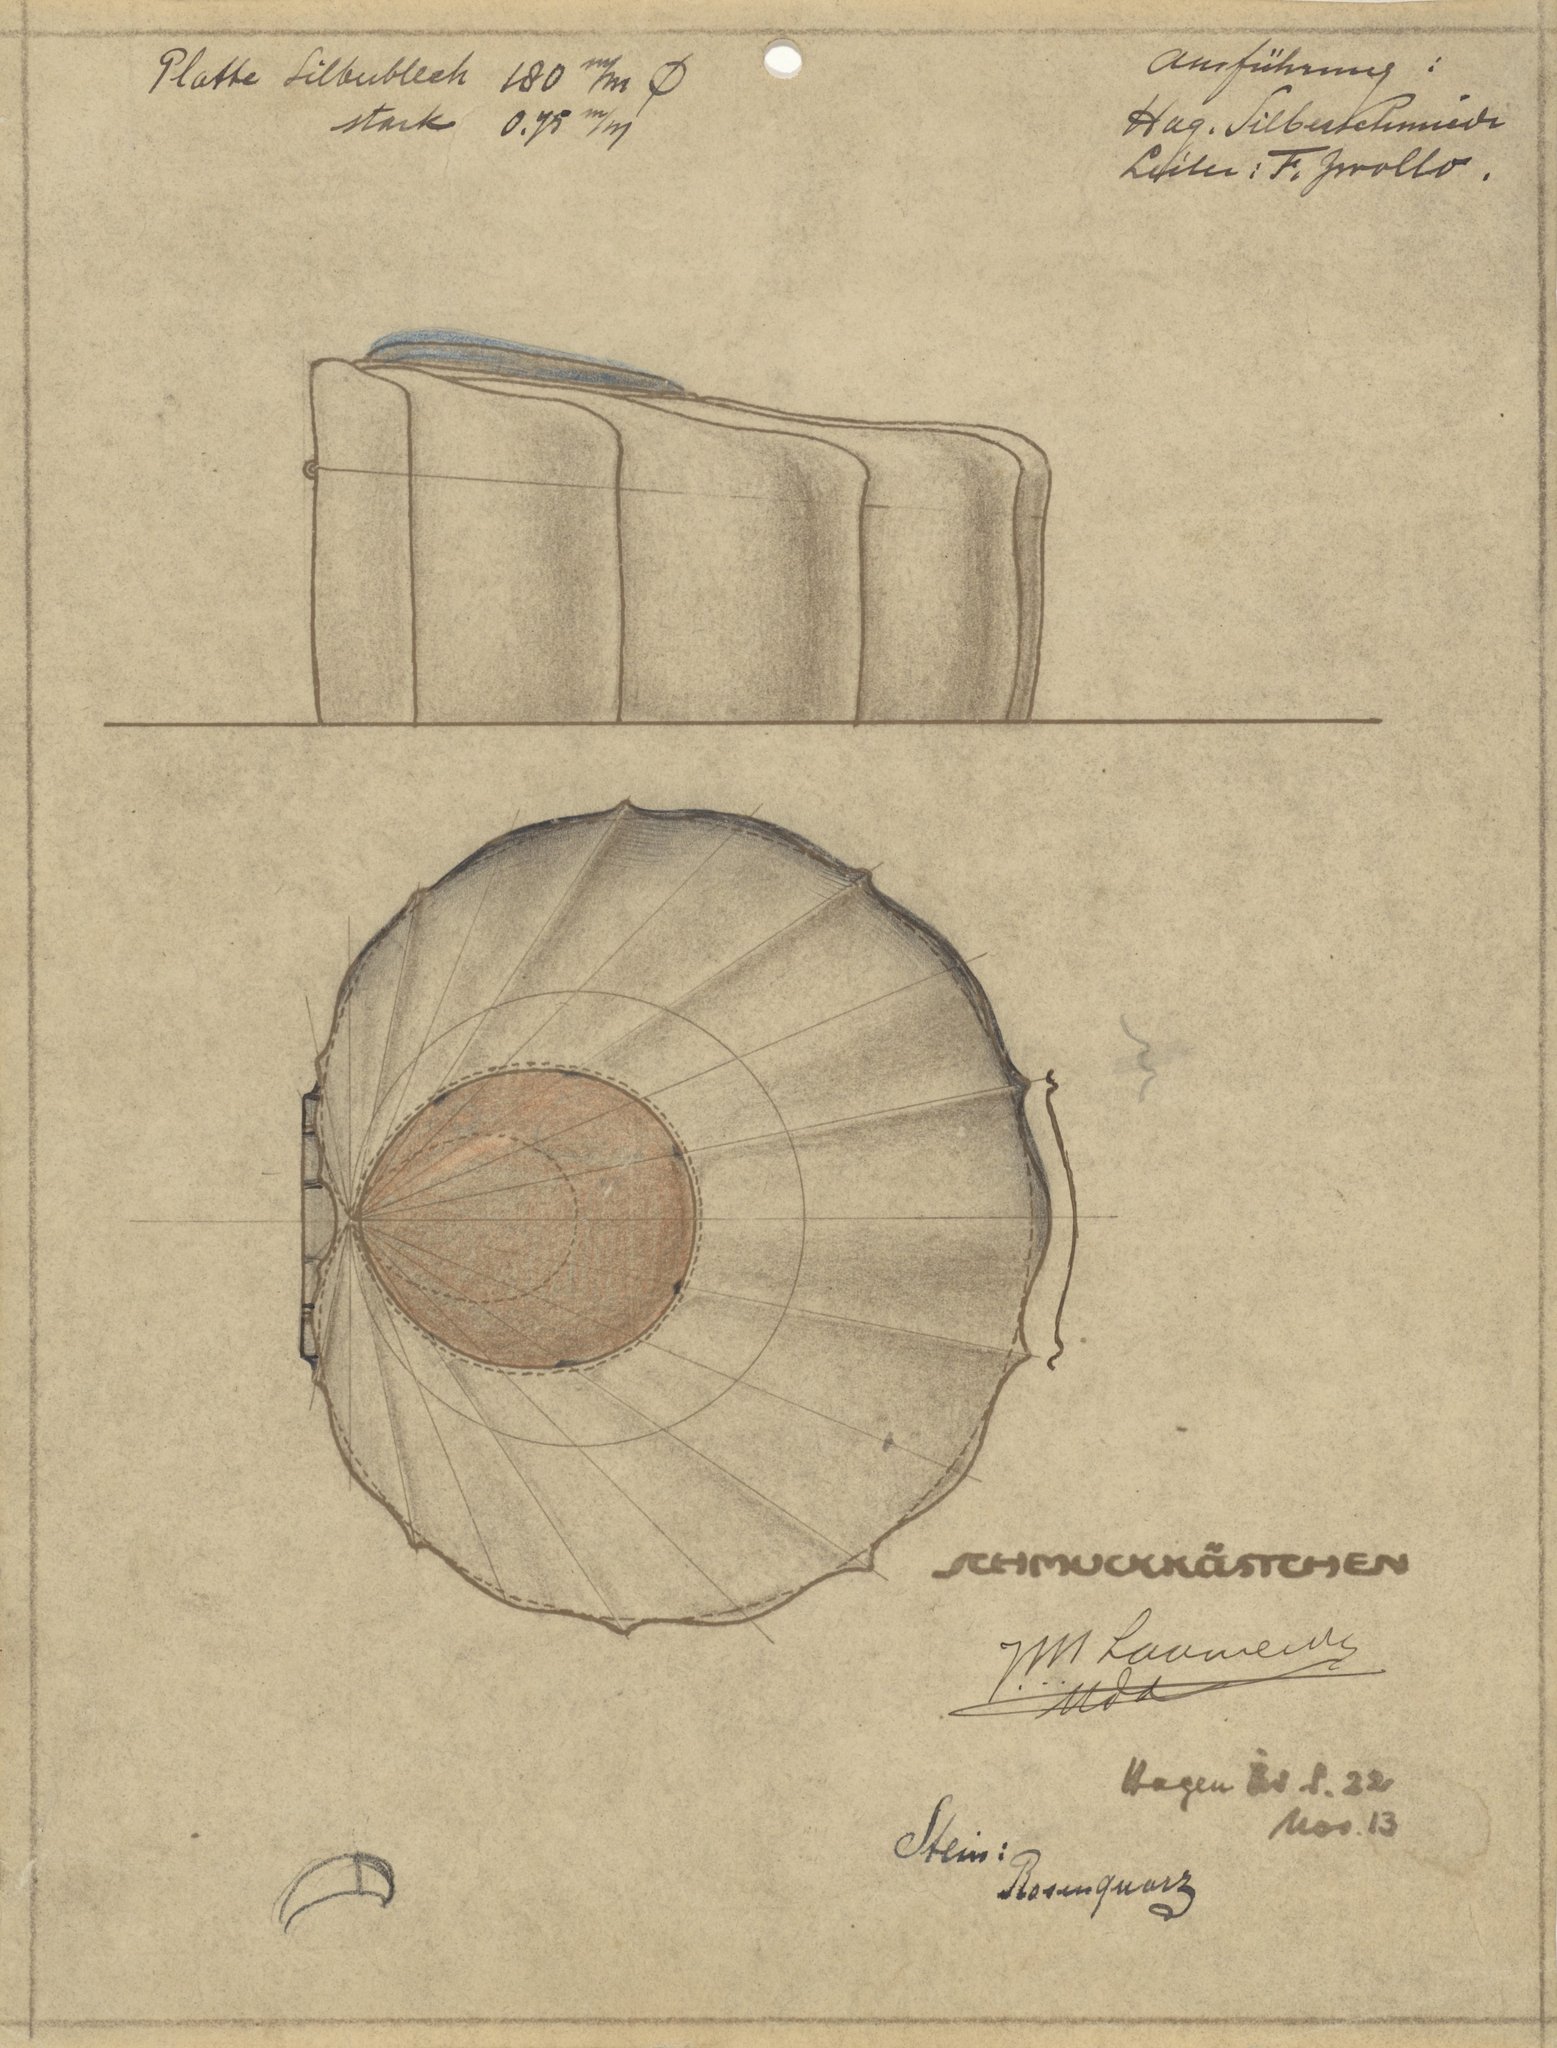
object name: photograph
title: Ontwerp voor een juwelenkistje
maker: mathieu lauweriks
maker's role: designer, draughtsman, print maker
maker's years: 1864-1932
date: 1911-1913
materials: ink, paper, pencil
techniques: blueprint, pen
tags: jewel-box